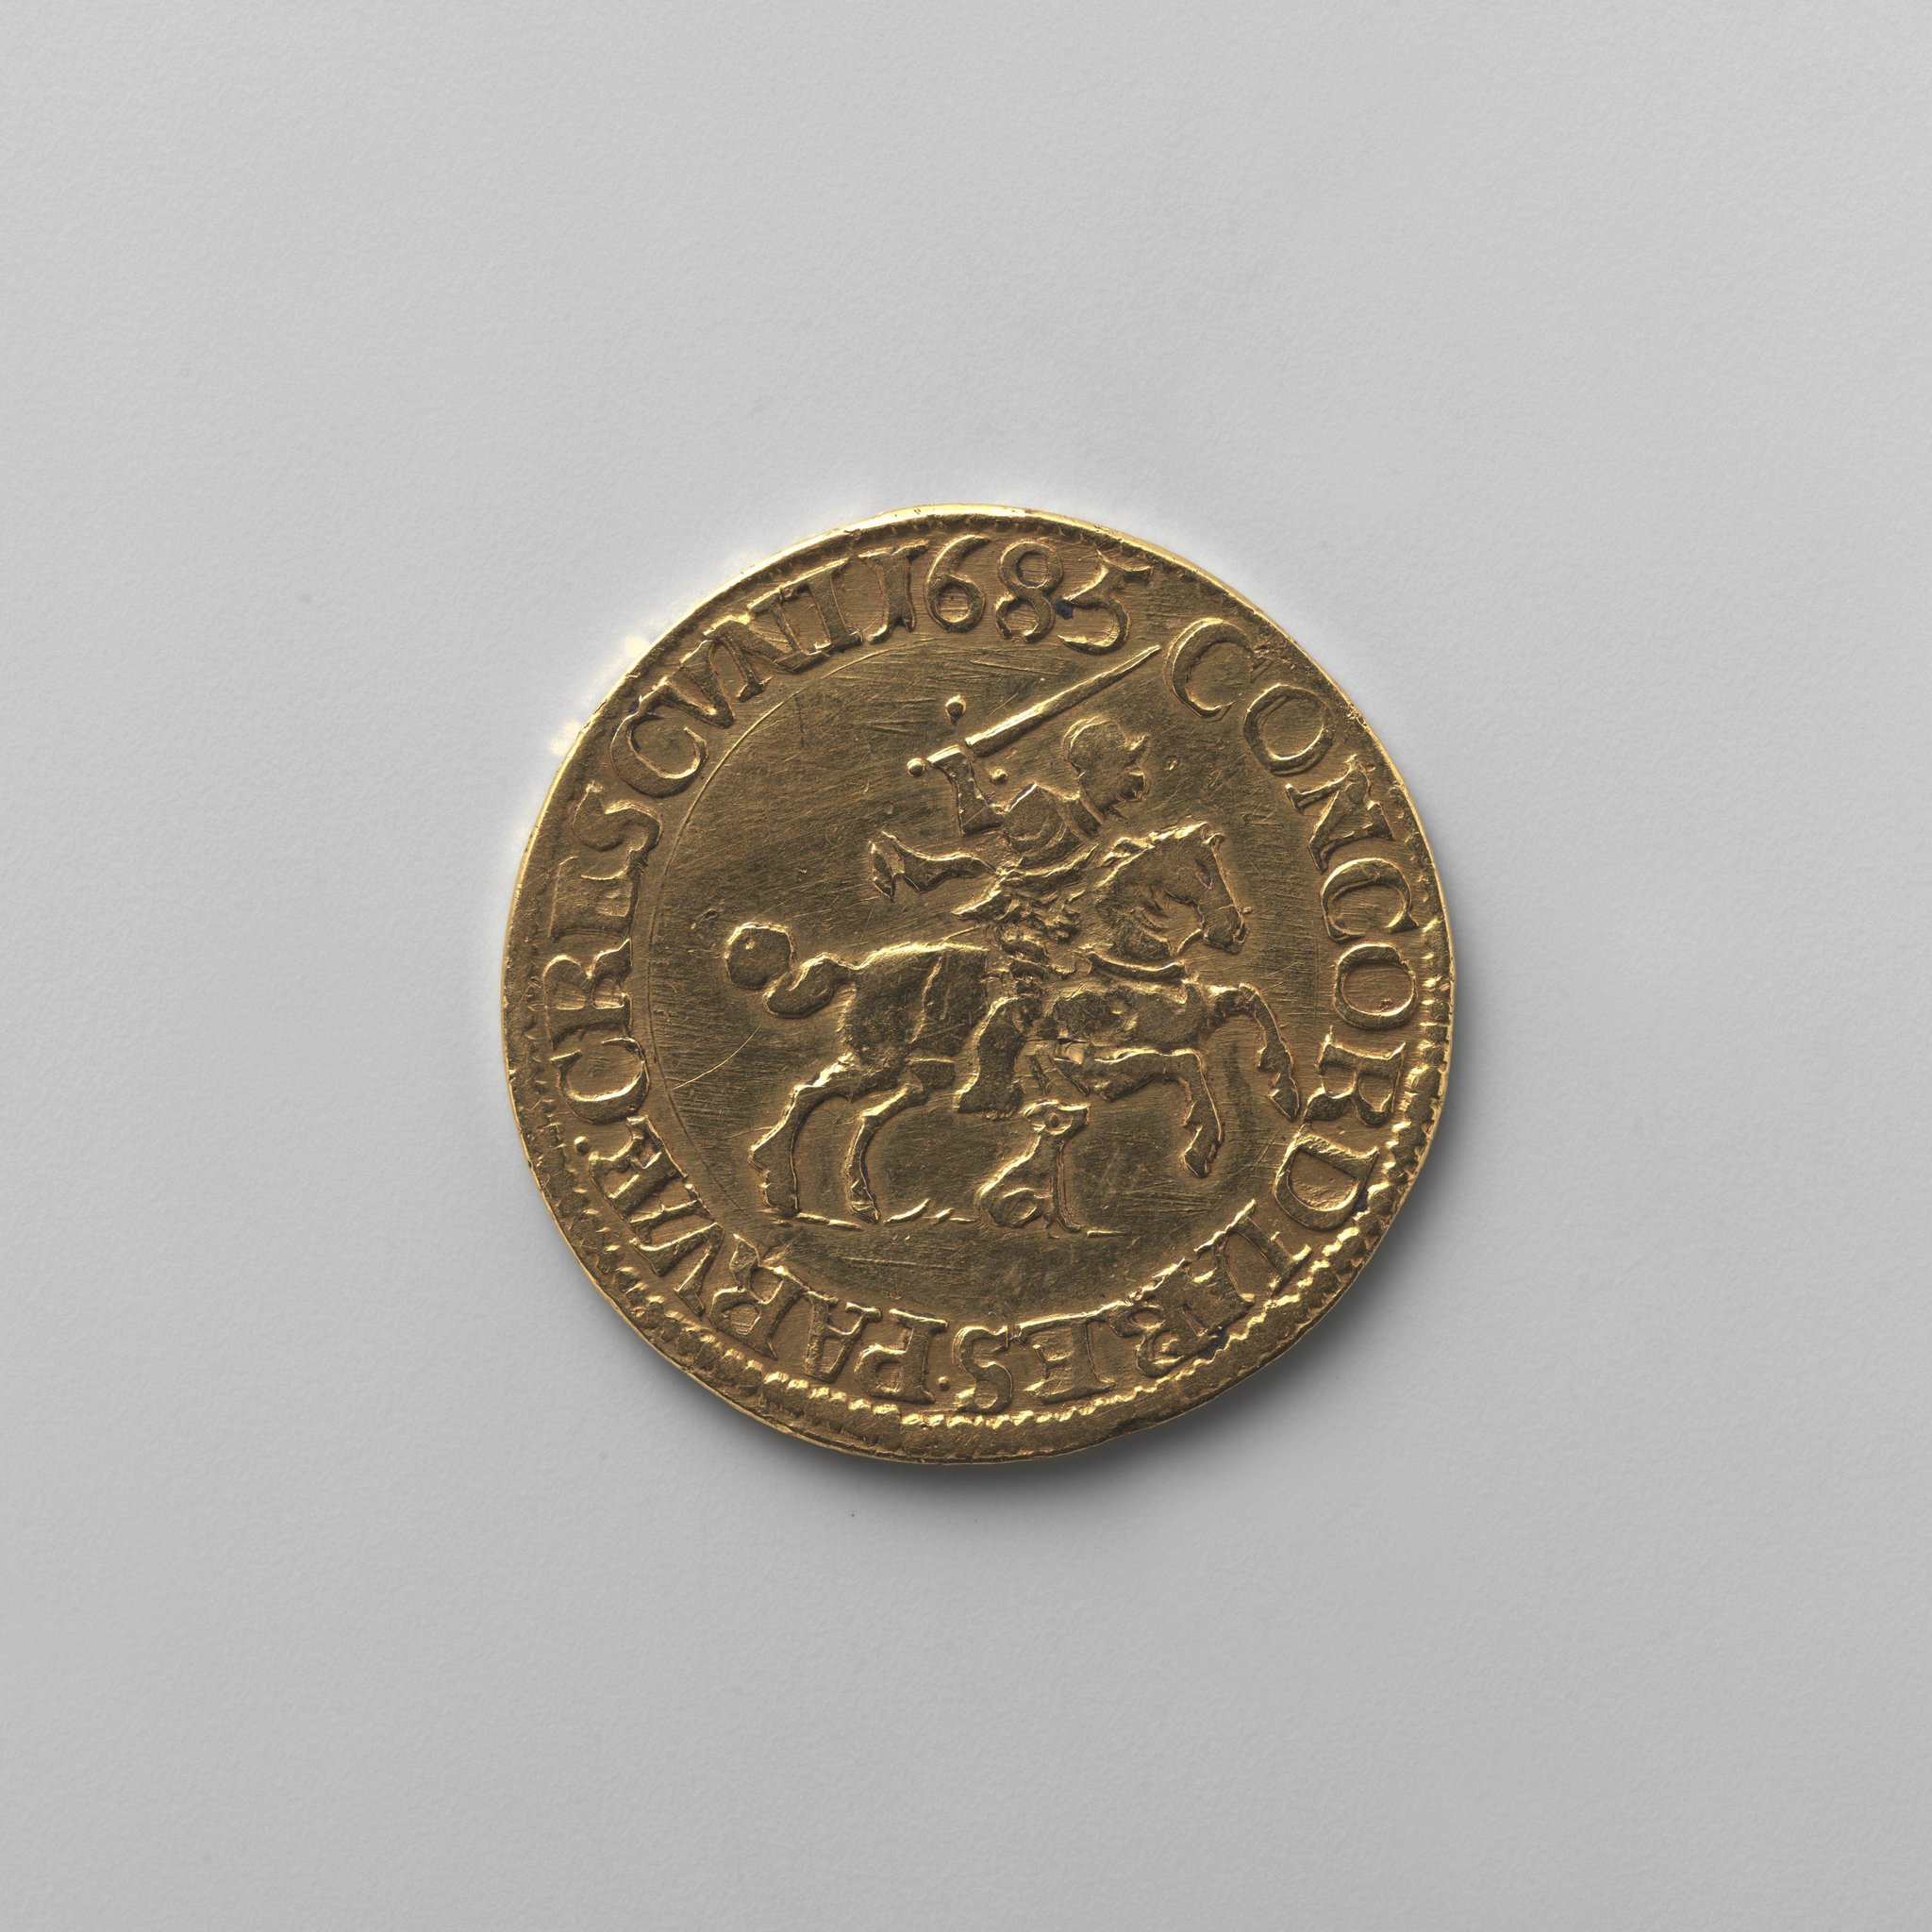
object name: rijderschelling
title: Gouden afslag van rijderschelling van Deventer, 1685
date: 1685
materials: gold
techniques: striking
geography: deventer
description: Gouden munt. Voorzijde: tyussen waarde-aanduiding 6 S gekroond versierd wapenschild van Deventer. Keerzijde: ridder met geheven zwaard te paard naar rechts rijdend. Jaartal in omschrift. Afslag in goud.